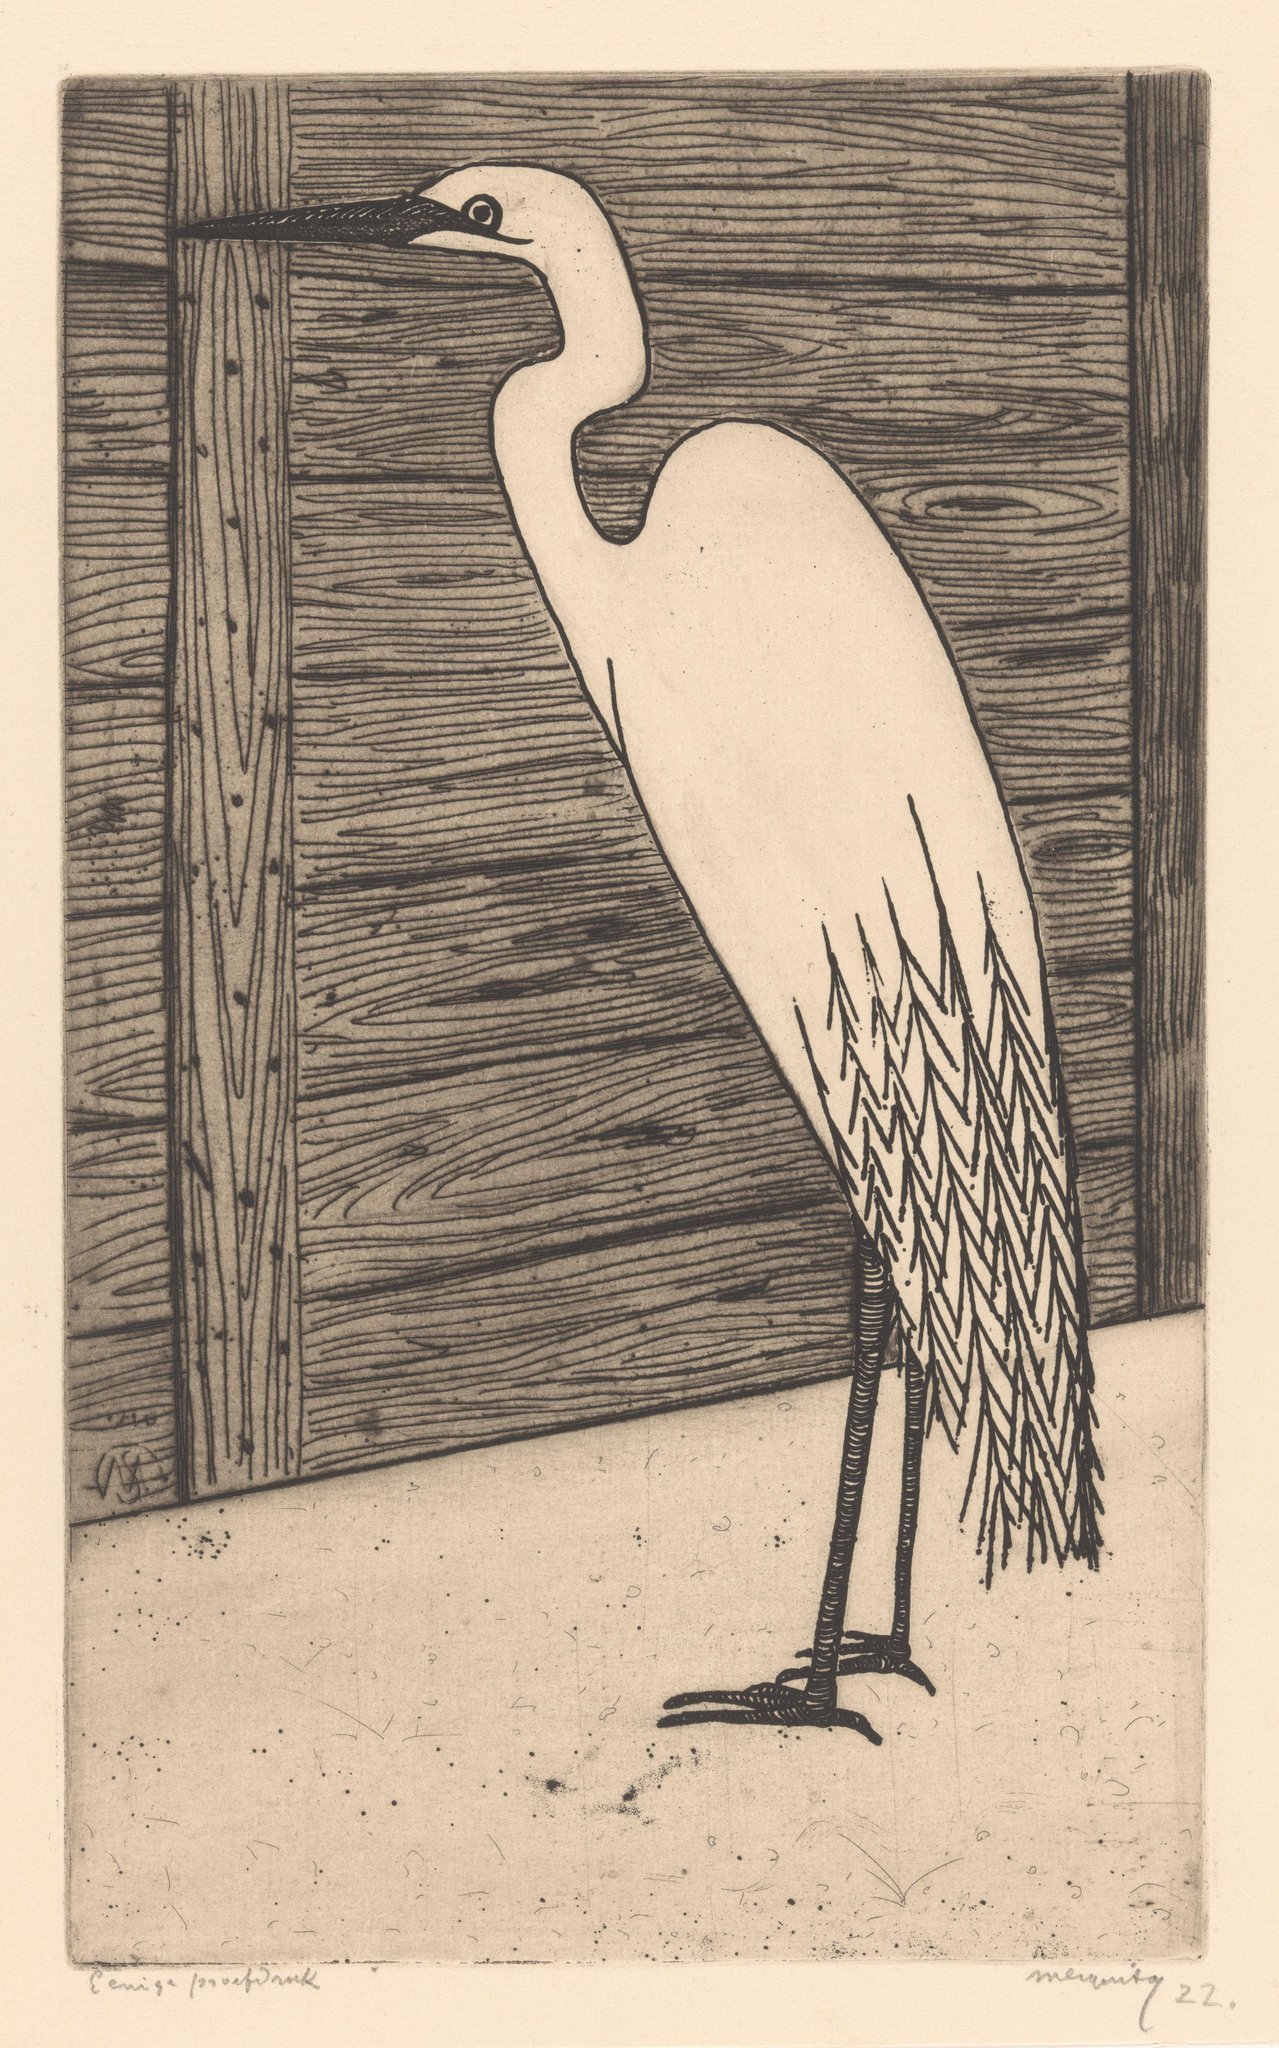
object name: print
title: Zilverreiger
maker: samuel jessurun de mesquita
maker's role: draughtsman, print maker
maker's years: 1868-1944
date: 1910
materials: paper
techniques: aquatint, etching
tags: shore-birds and wading-birds: heron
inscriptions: number: ‘22.’, collector's mark: Lugt 2228